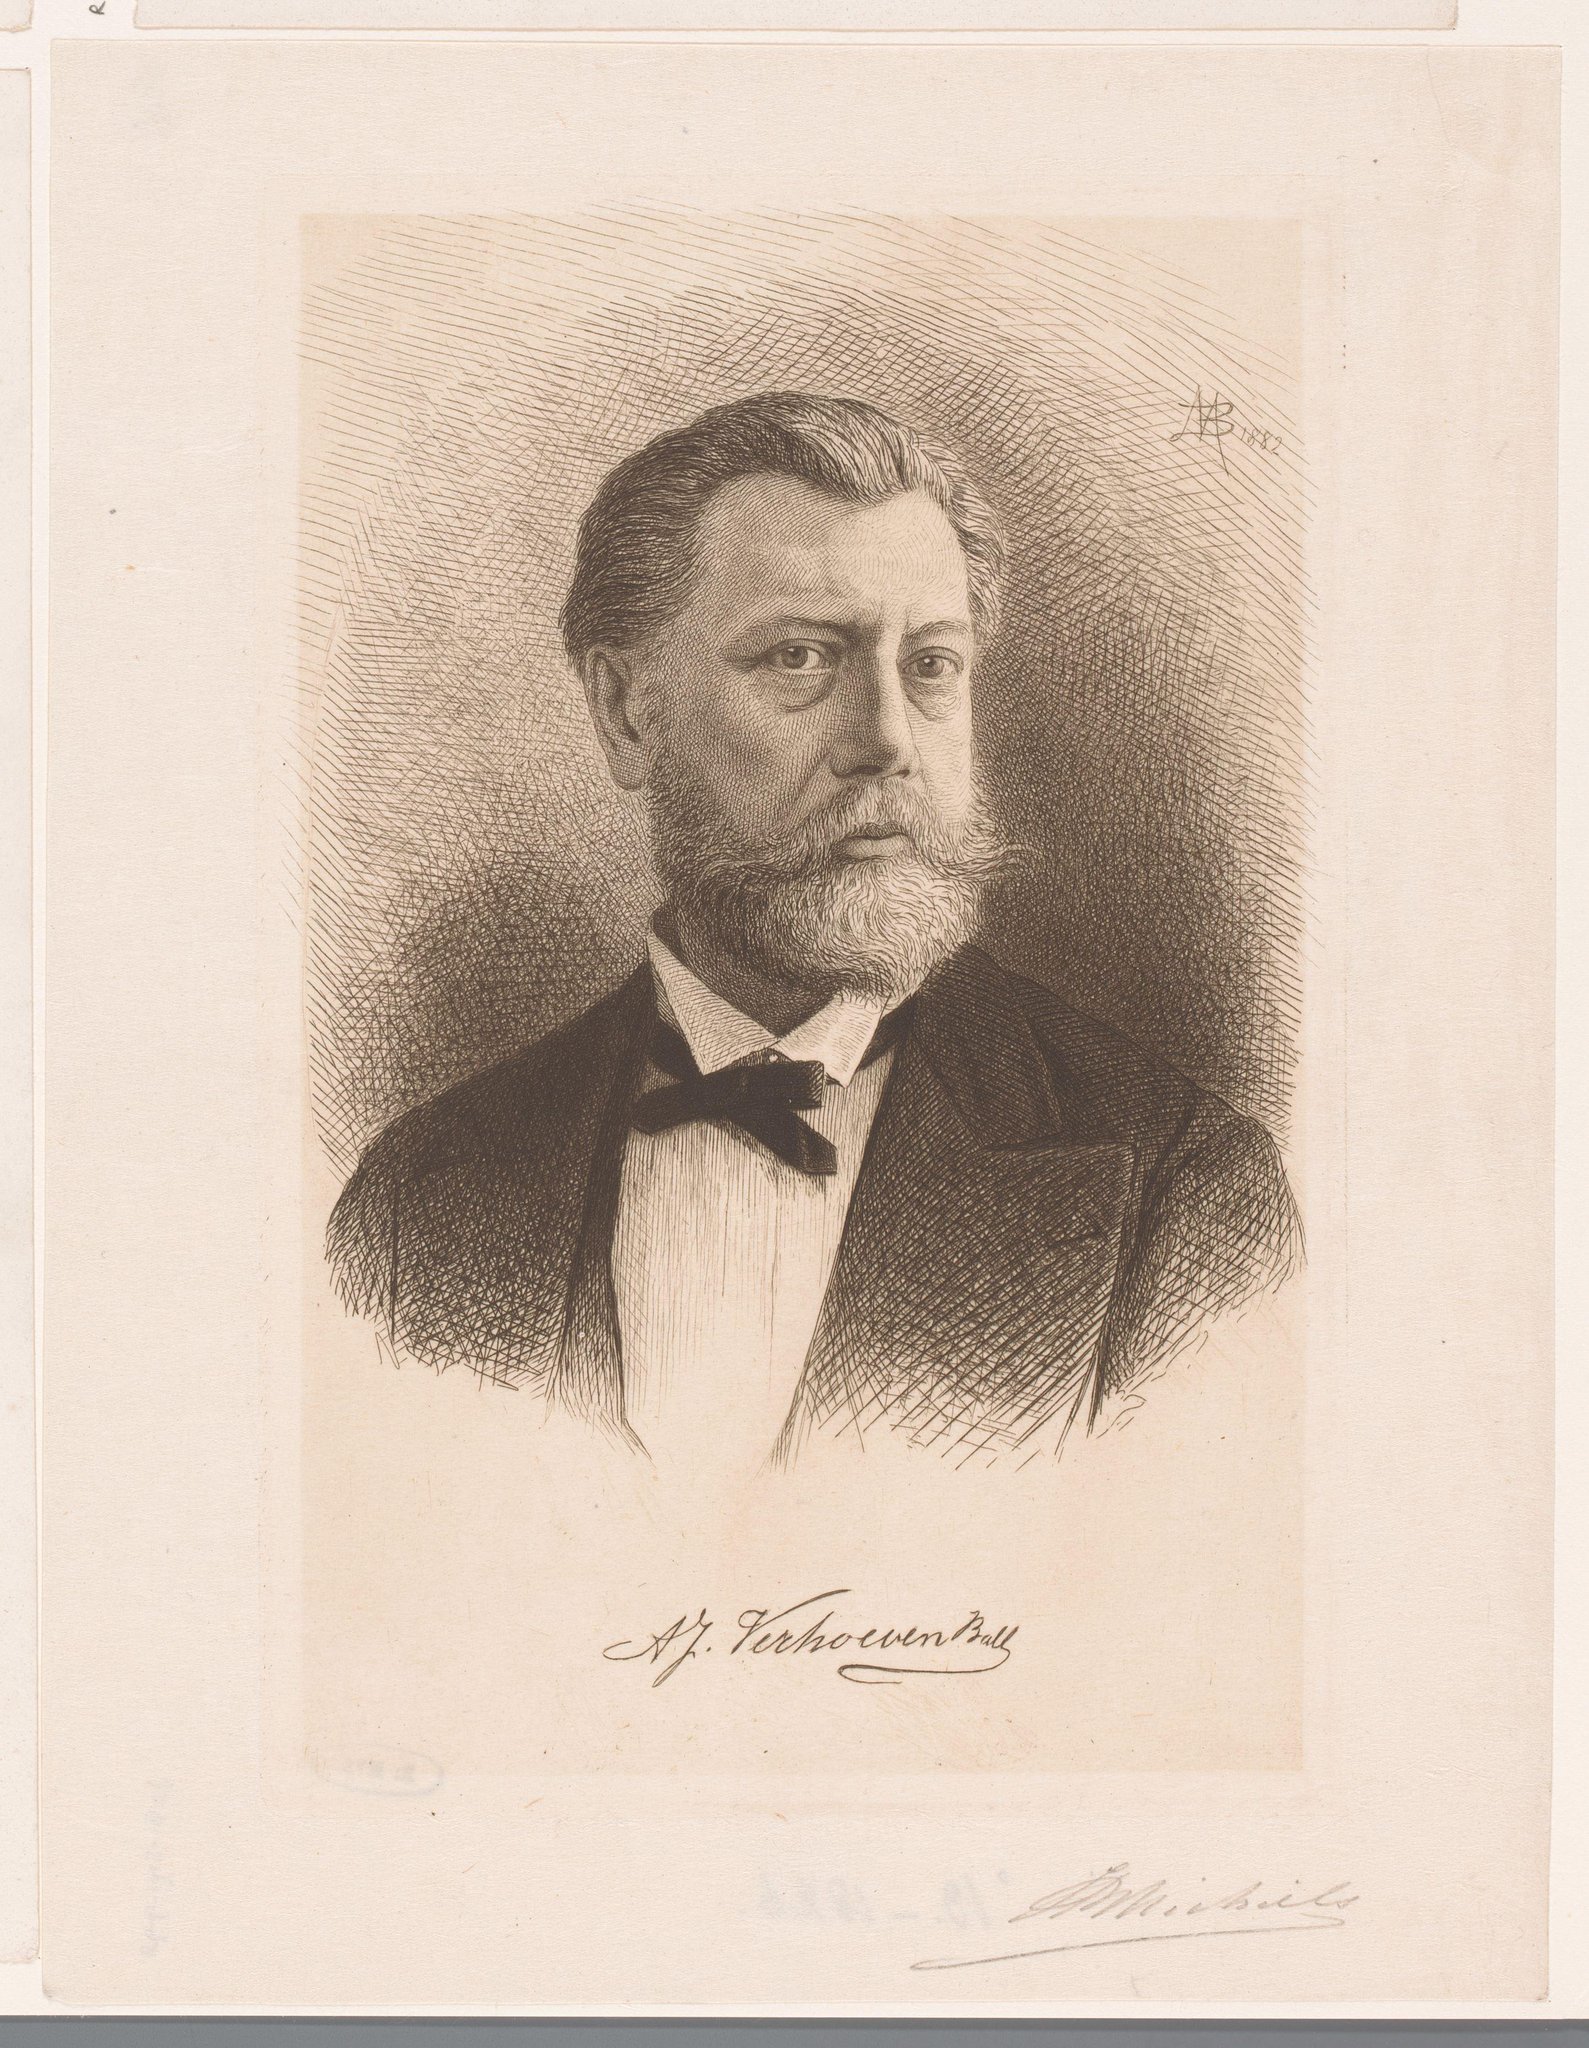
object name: print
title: Portret van Adrien Joseph Verhoeven-Ball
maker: jean baptiste pierre michiels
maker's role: print maker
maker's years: 1821-1890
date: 1882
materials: paper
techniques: etching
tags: antwerp, print maker, draughtsman, adrien joseph verhoeven-ball, adult man, historical persons, portrait, self-portrait of artist, beard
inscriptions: collector's mark: Lugt 2228, mark: ‘Antwerpsche Etsers 1880’